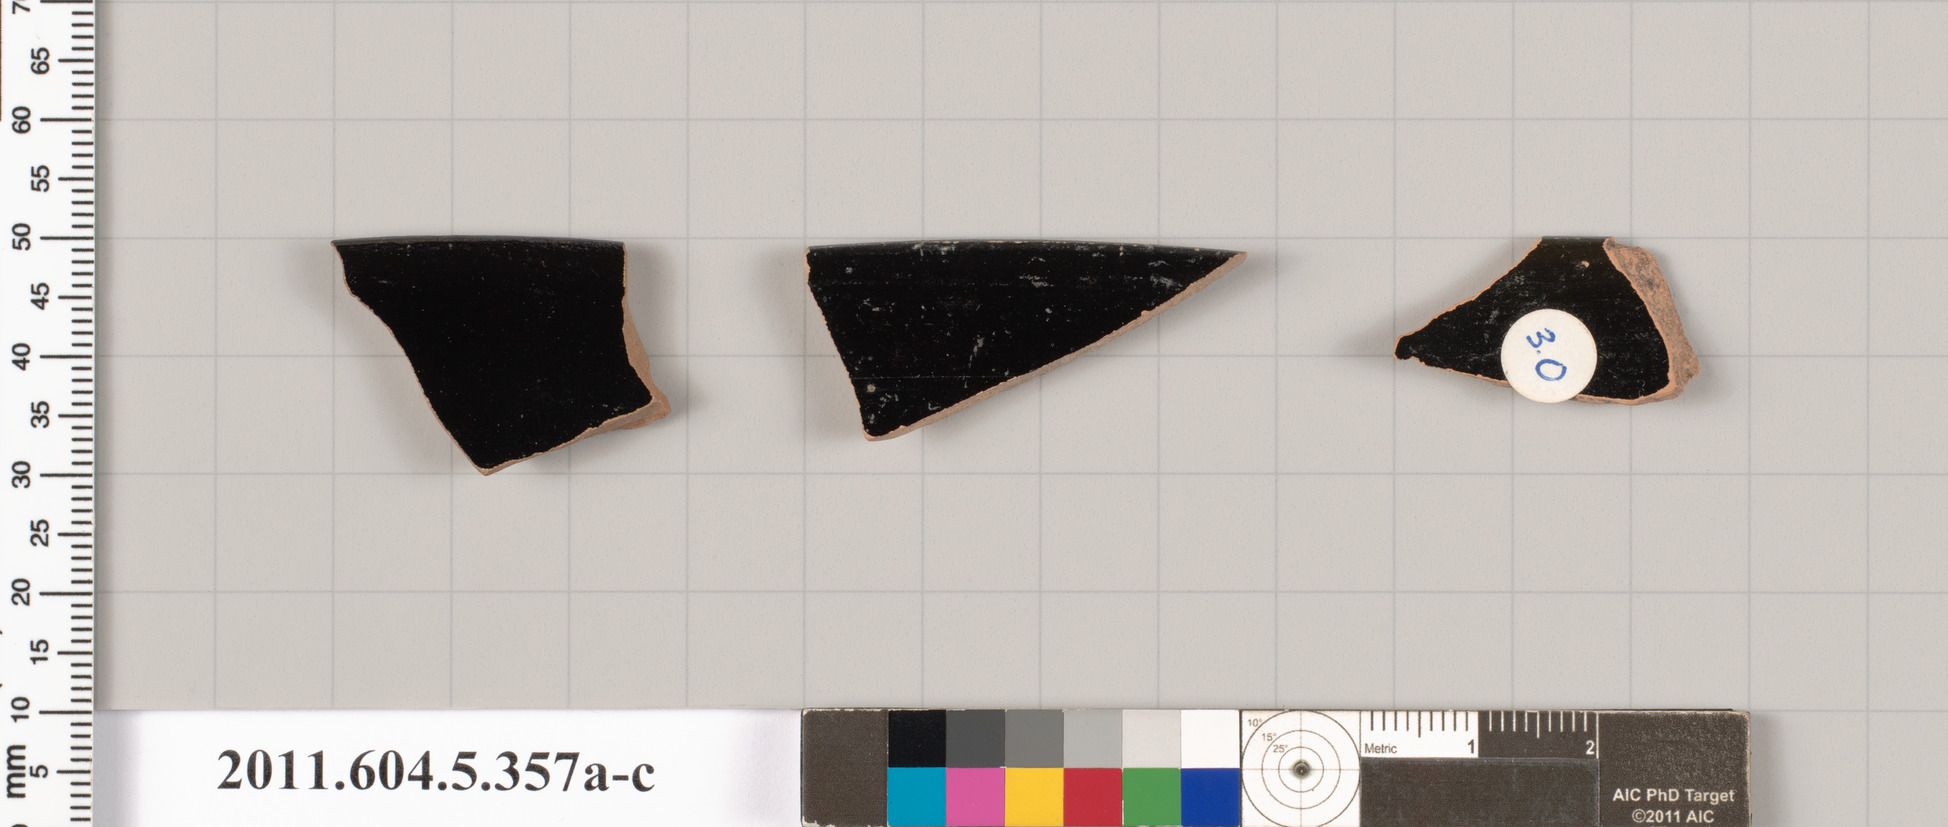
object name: kylix fragment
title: Terracotta rim fragments of kylikes (drinking cups)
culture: greek, attic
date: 600-401 BCE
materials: terracotta